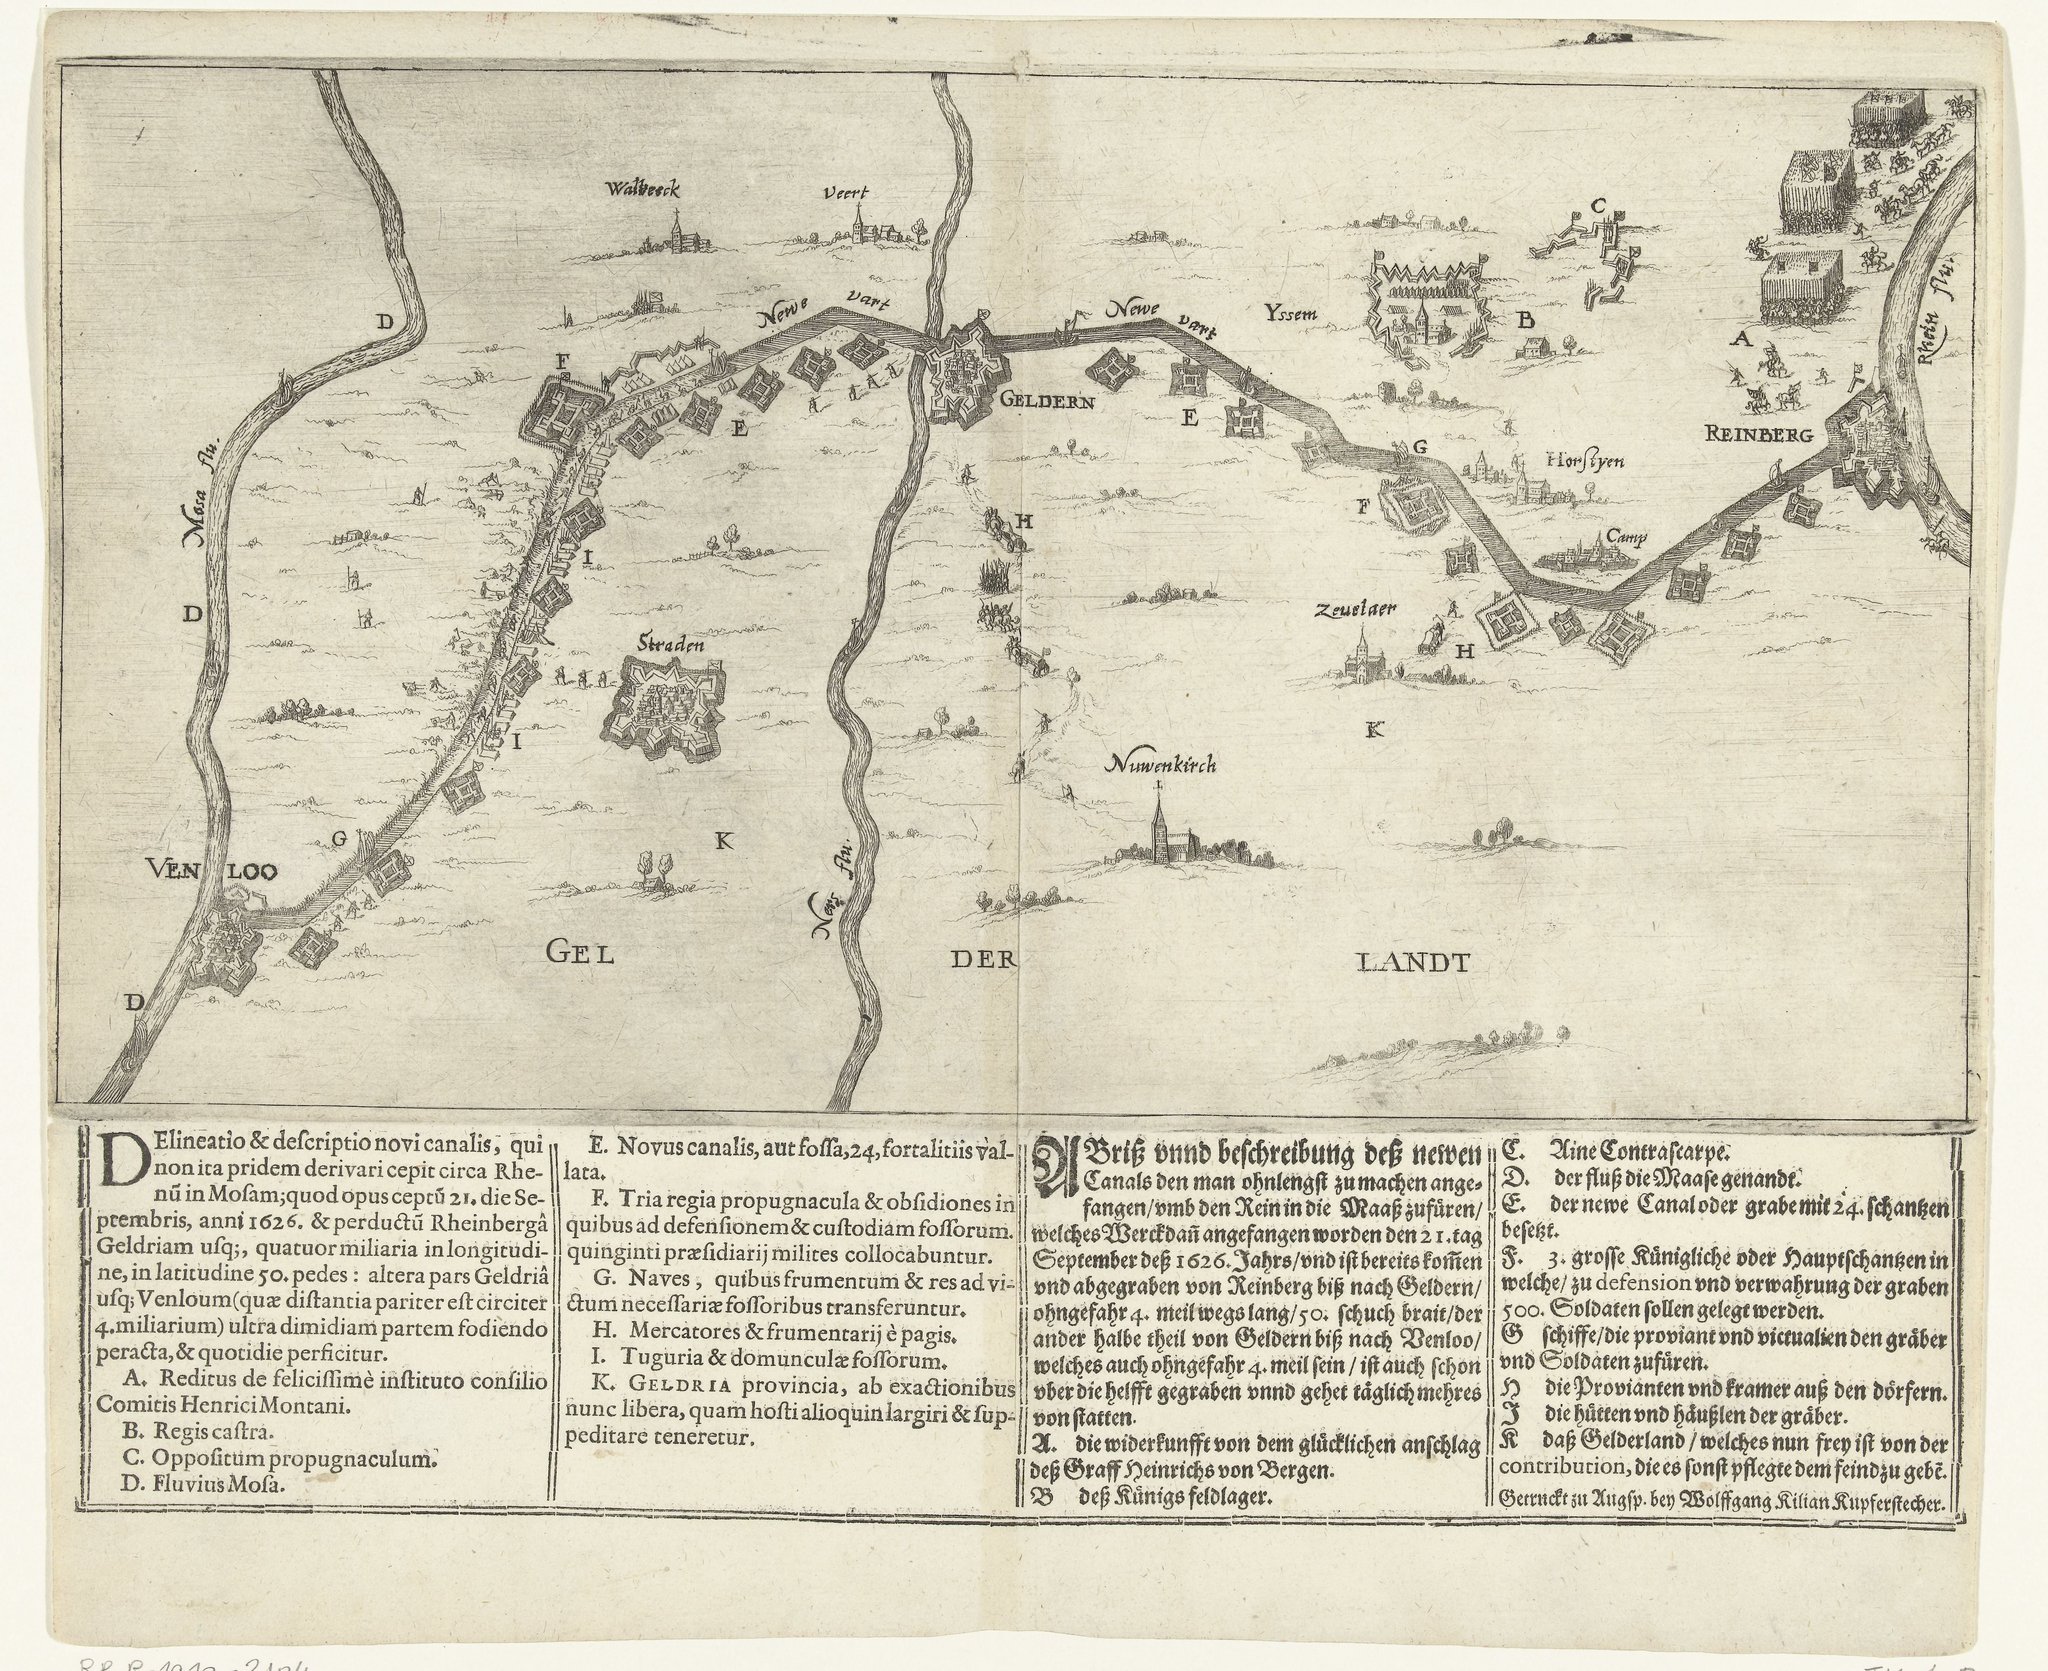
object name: print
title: Abriss unnd beschreibung dess newen Canals den man ohnlengst zu machen angefangen, umb den rein in die Maass zufüre, welches Werck an[] angefangen worden den 21. tag September dess 1626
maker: wolfgang kilian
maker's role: print maker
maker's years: 1581-1662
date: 1626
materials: paper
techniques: etching, letterpress printing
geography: germany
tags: infante van spanje isabella clara eugenia, construction of canal, maps of separate countries or regions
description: Het begin van de graafwerkzaamheden voor de aanleg van het kanaal tussen de Rijn en de Maas, genaamd Fossa Eugeniana, 21 september 1626. Vastgeplakt onder de prent een tekstblad met 2 kolommen in het Latijn en 2 kolommen in het Duits.